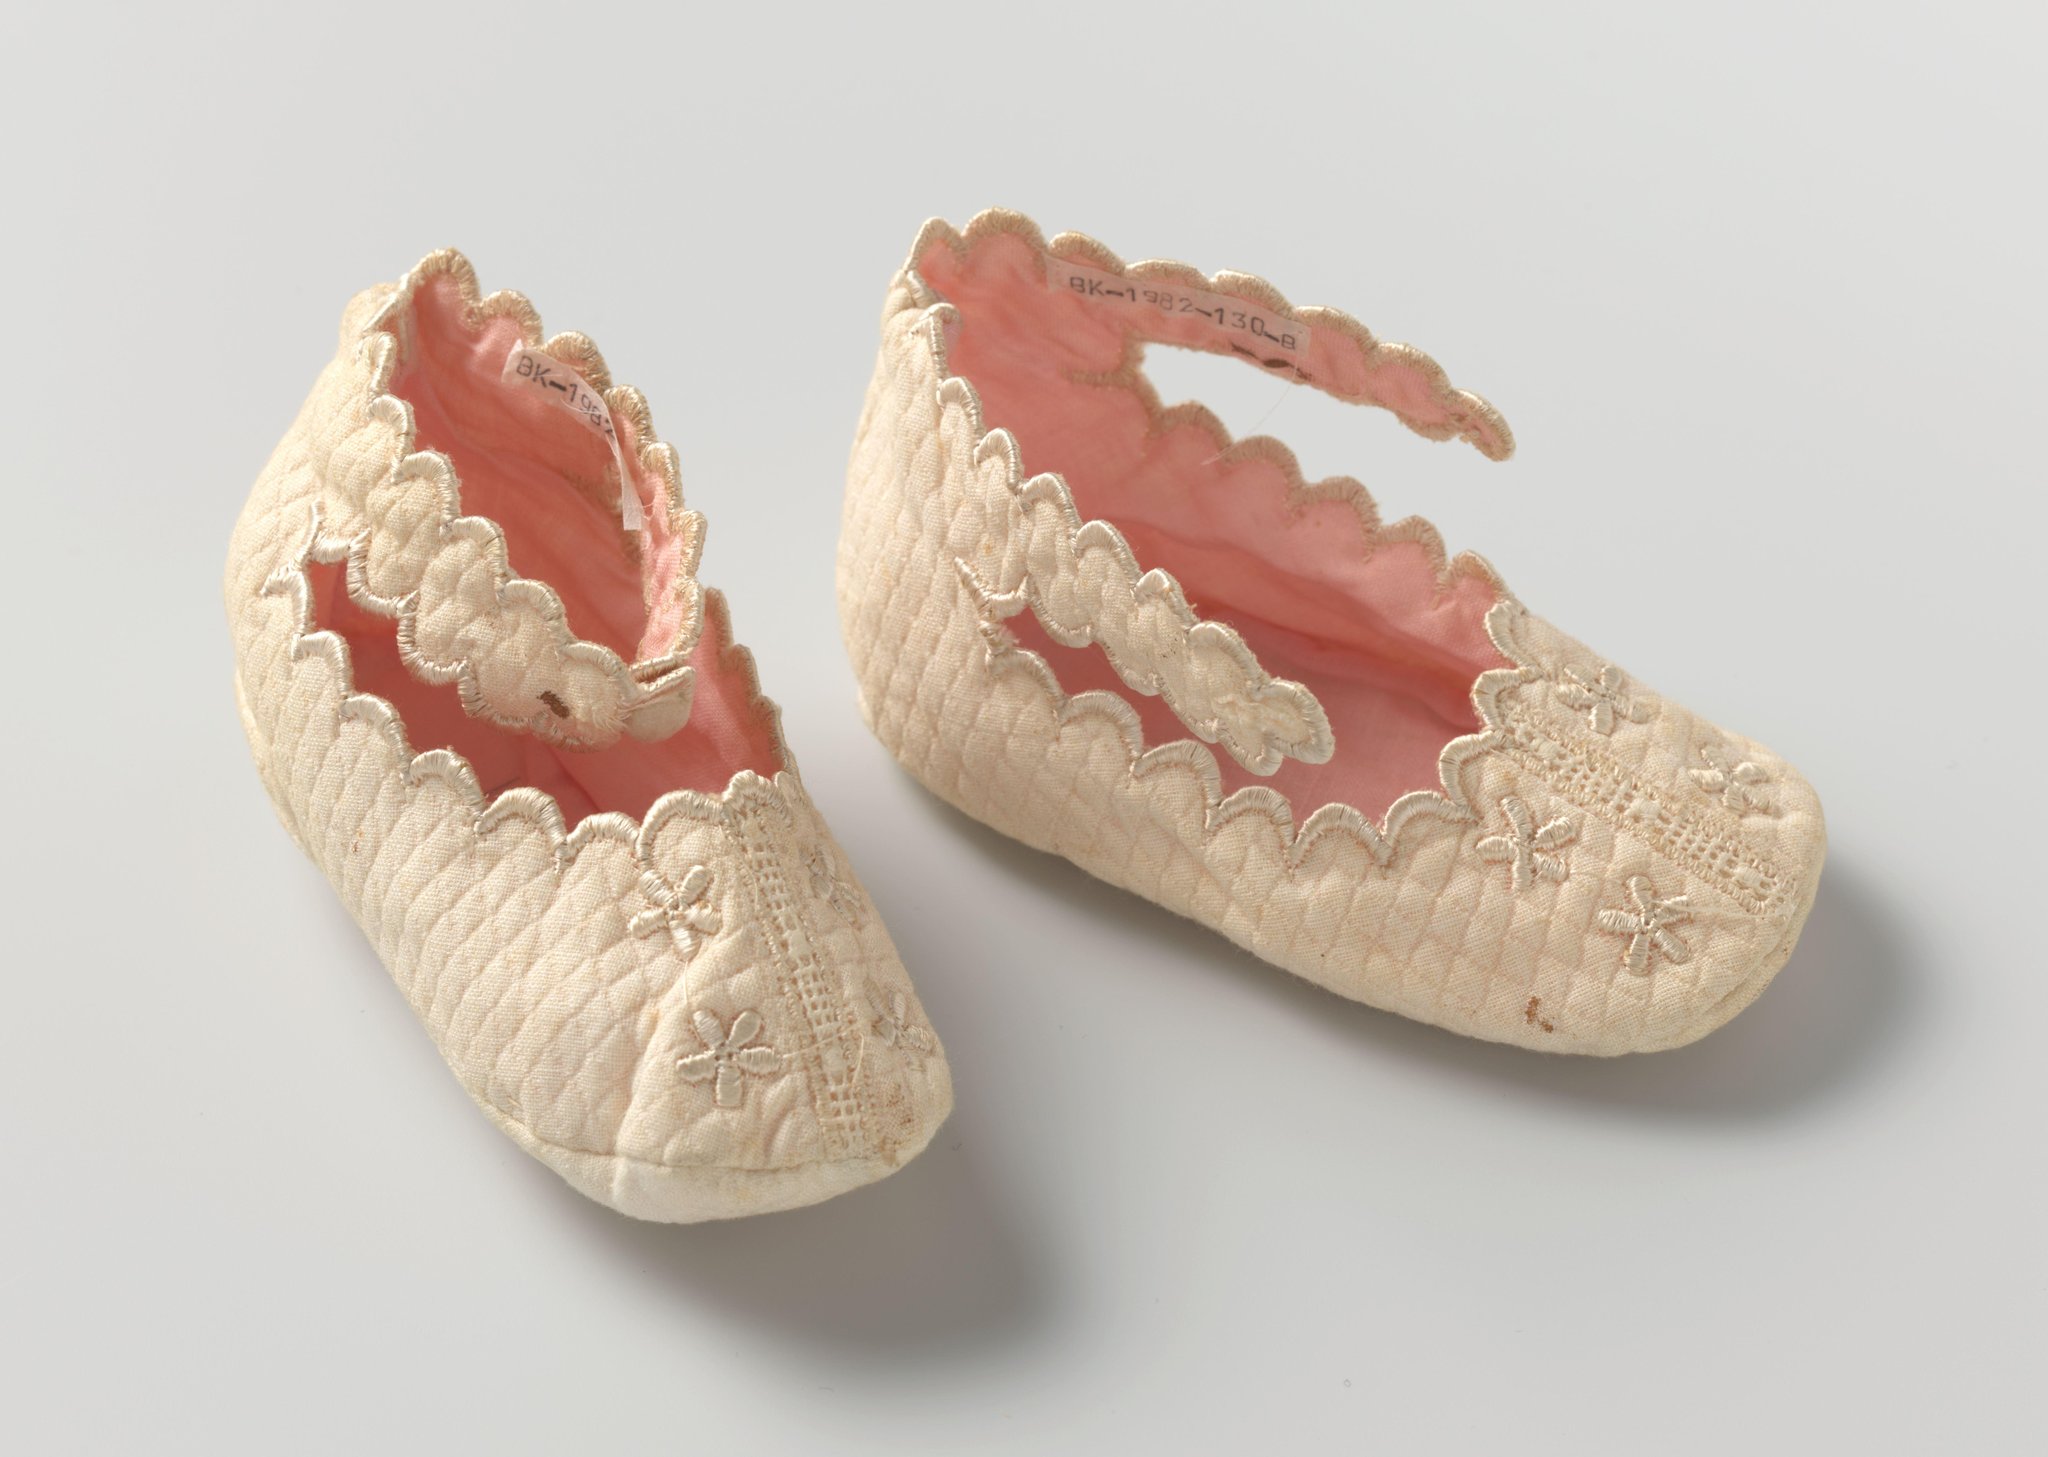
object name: kinderslof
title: Kinderslof van crèmekleurig wafelpiqué, geborduurd met beige zijden bloemetjes en afgezet met gefestonneerde schulpen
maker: Anonymous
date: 1891-1892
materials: cotton, linen, velvet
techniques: embroidered, weave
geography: dutch east indies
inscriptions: inscription: ‘19’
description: Kinderslof van crèmekleurig wafelpiqué, geborduurd met zijden bloemetjes en afgezet met gefestonneerde schulpjes. Model: plat, uitgesneden voorblad, hoge hiel met twee bandjes die oorspronkelijk middenvoor sloten d.m.v. een fluwelen knoopje (dat nu echter ontbreekt), gevoerd met roze linnen. Versiering: midden op de neus een geborduurde verticale band met aan weerszijden twee geborduurde bloemetjes. De schulprandjes zijn gefestoneerd met zijde. Fluwelen knoopje ontbreekt.